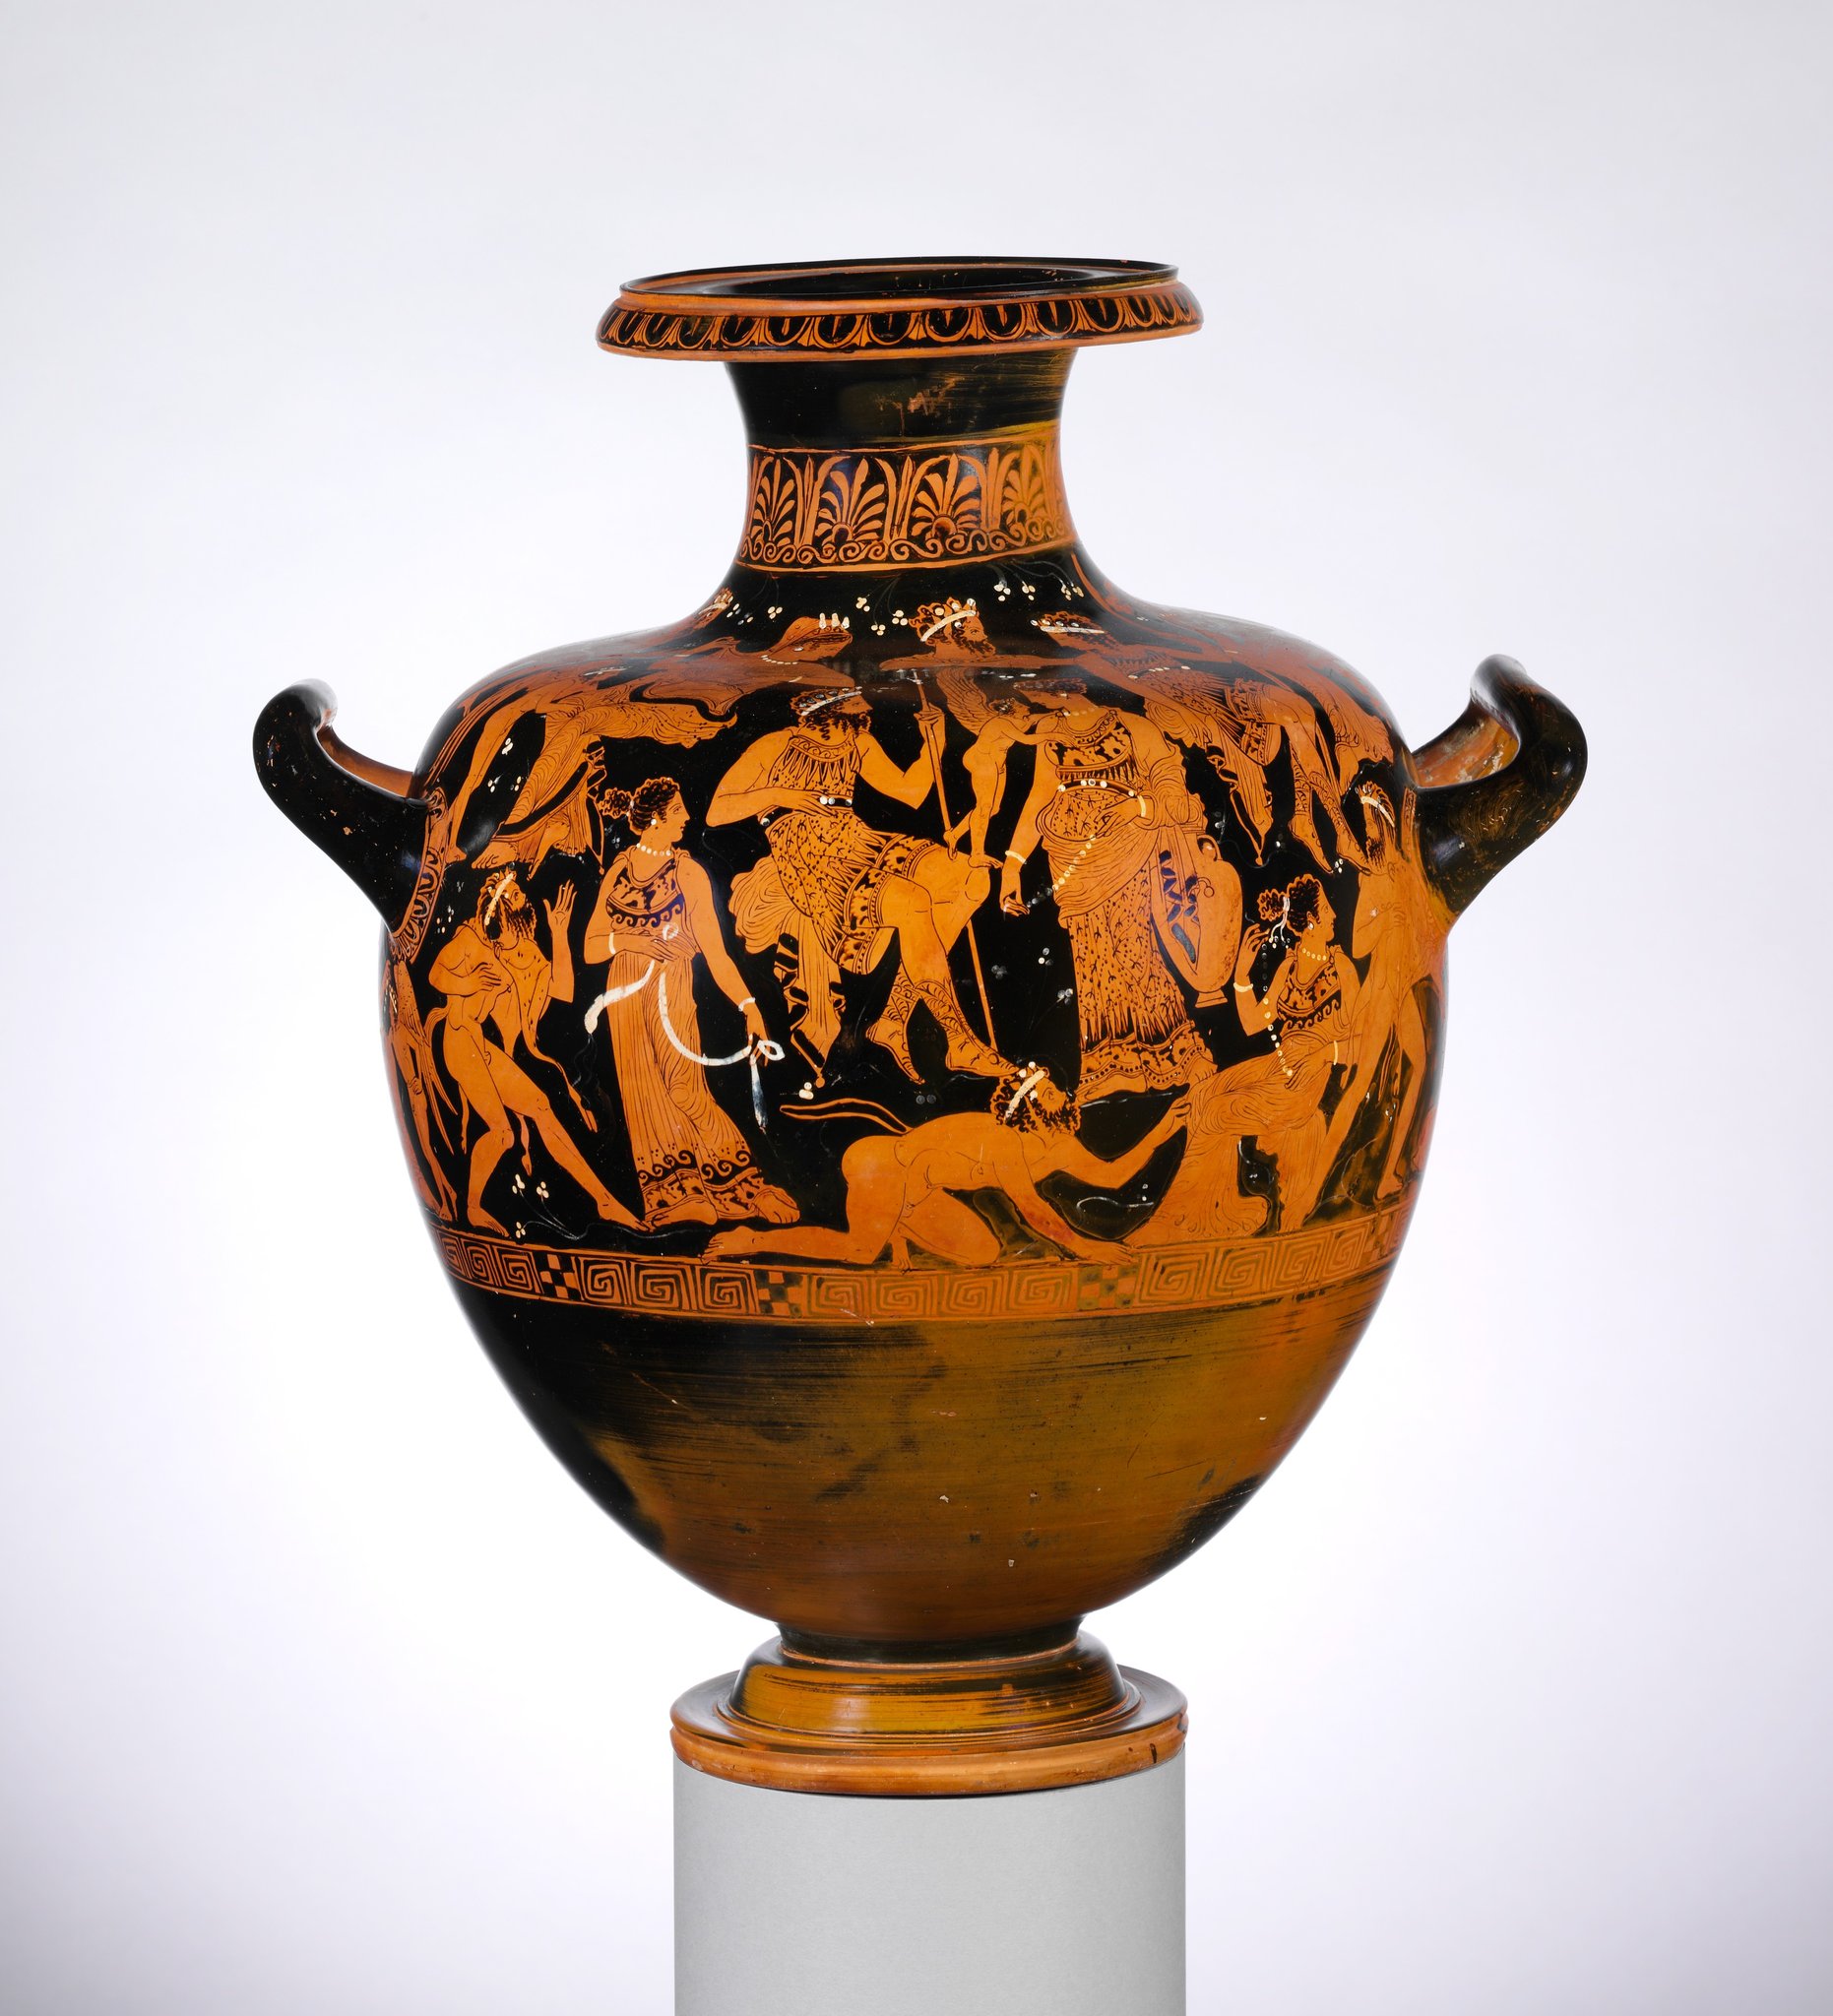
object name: hydria, kalpis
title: Terracotta hydria: kalpis (water jar)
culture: greek, attic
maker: meleager painter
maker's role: artist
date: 400-368 BCE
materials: terracotta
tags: aphrodite,poseidon,maenads,satyrs